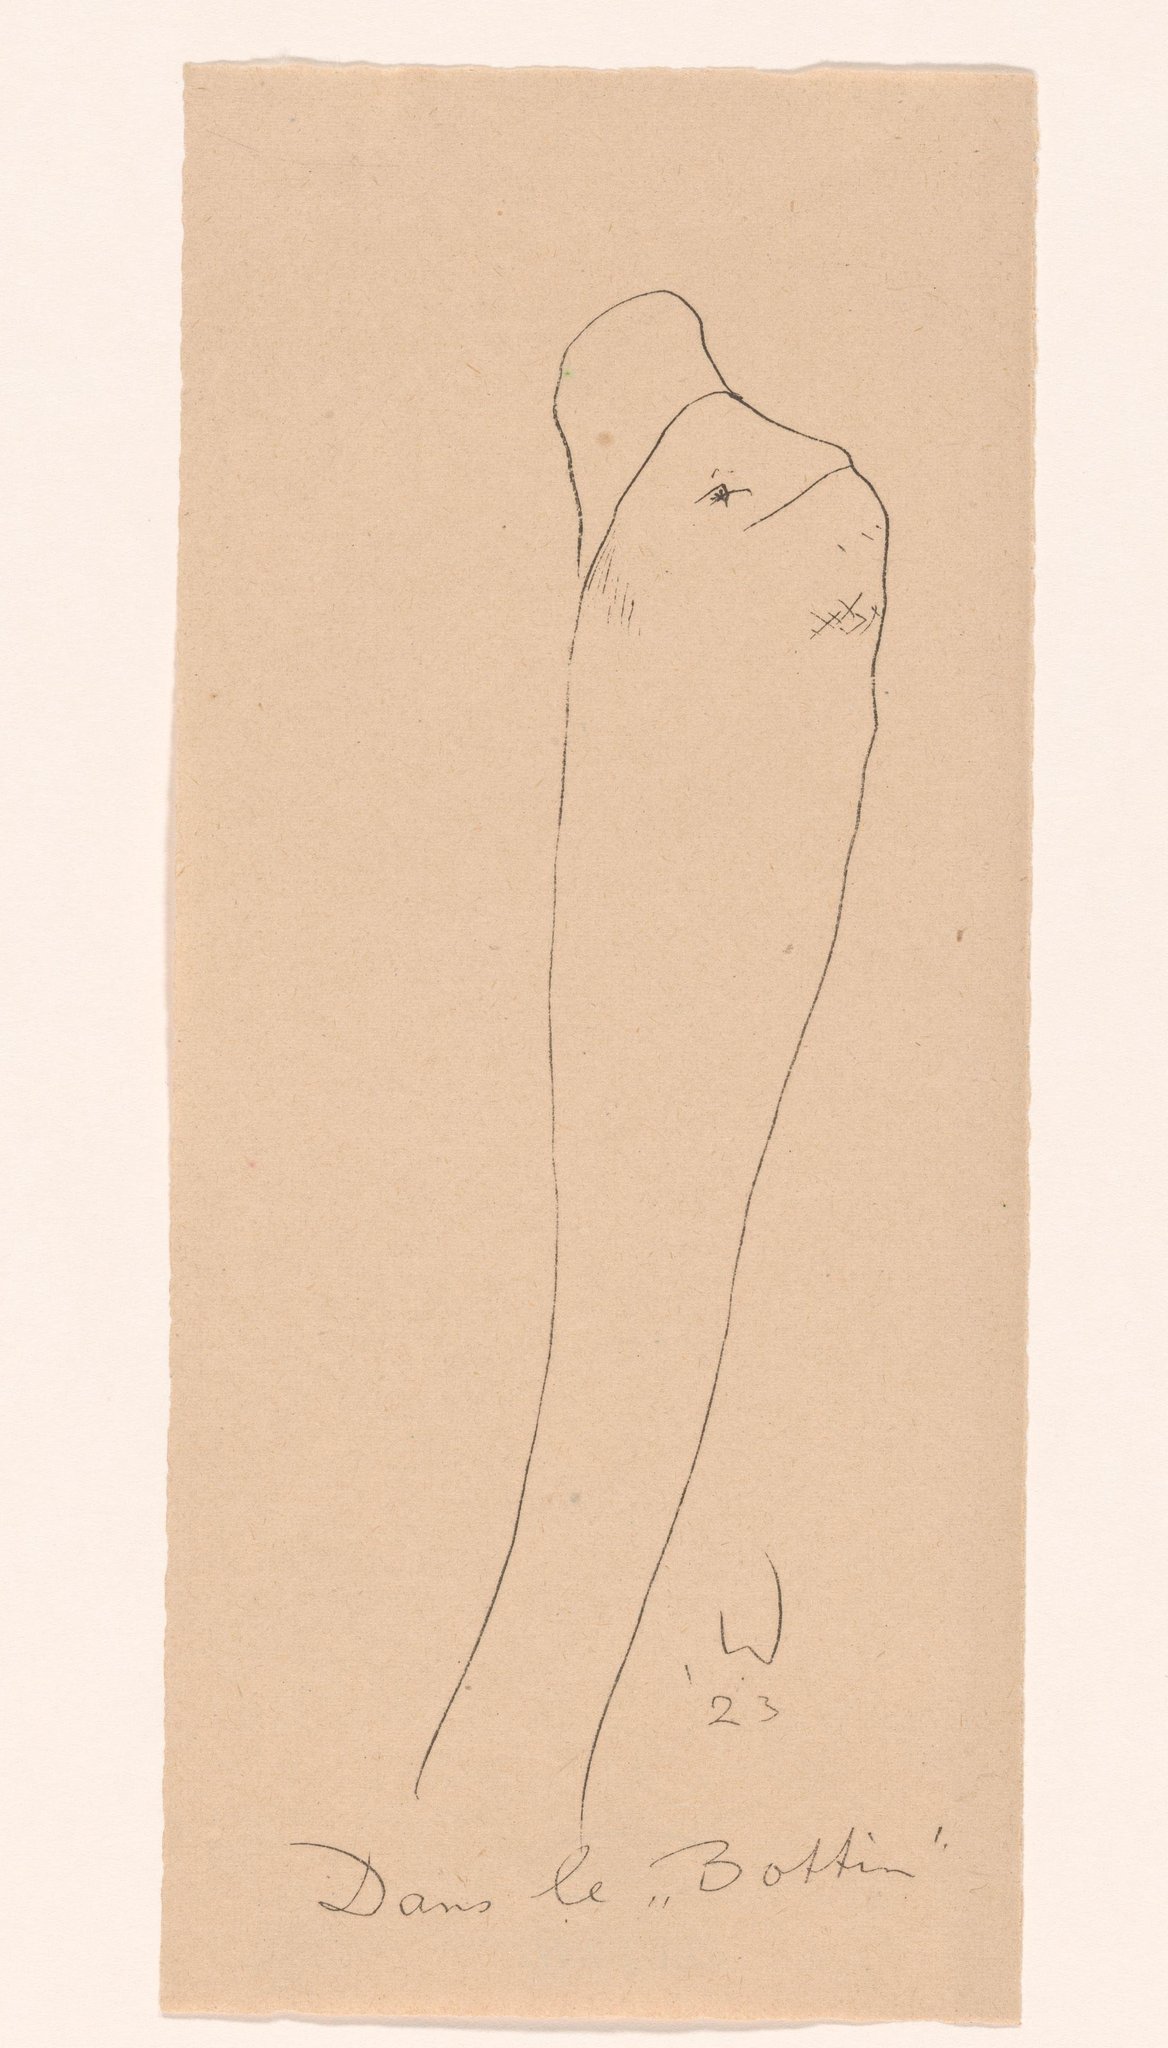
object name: print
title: Idealisten II en verdere Kanttekeningen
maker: erich wichmann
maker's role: print maker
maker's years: 1890-1929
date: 1923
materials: paper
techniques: lithograph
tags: caricatures (human types)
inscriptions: collector's mark: Lugt 2228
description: Langwerpige geabstraheerde figuur met een muts.